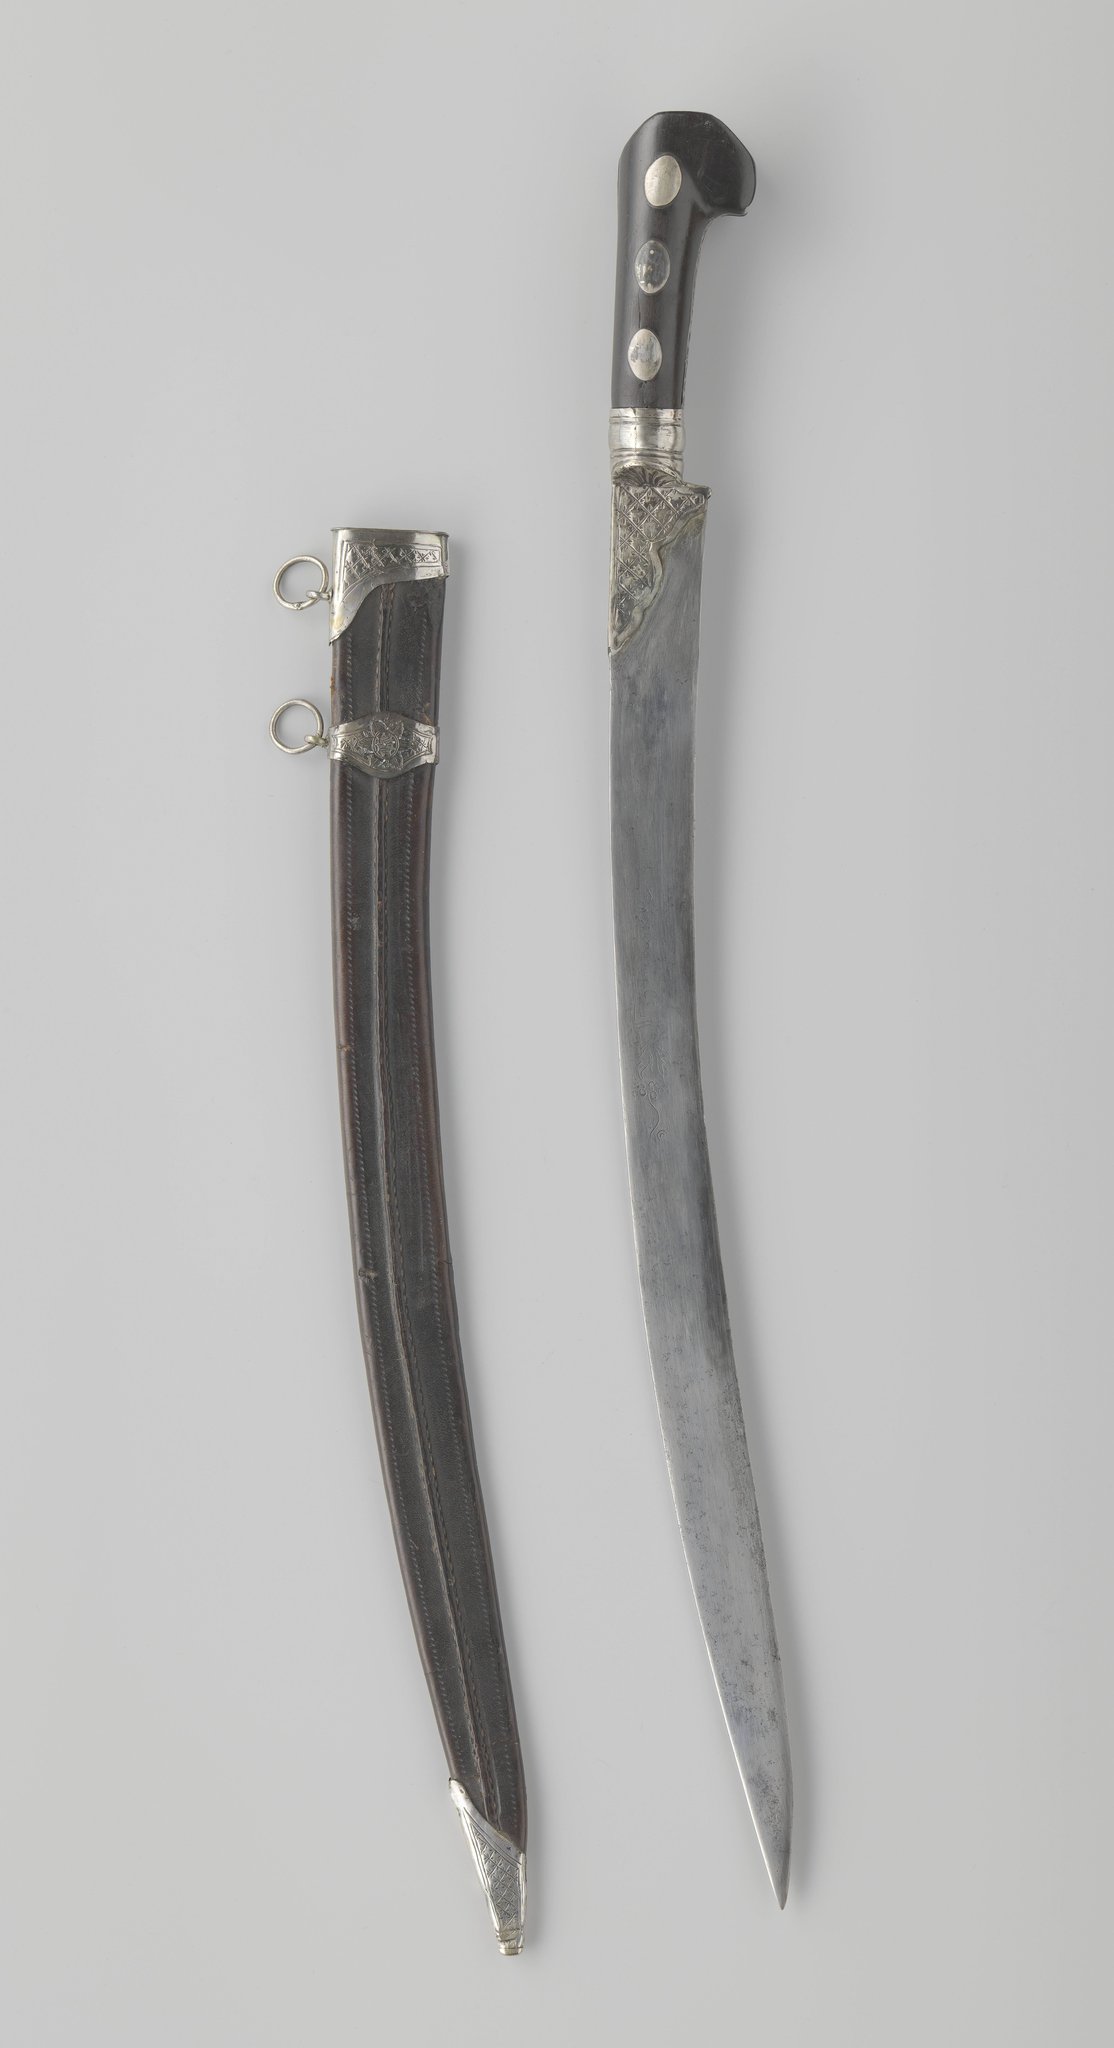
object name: yatagan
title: Yatagan met ebbenhouten gevest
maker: Anonymous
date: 1500-1699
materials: wood, iron, leather, silver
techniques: inlay, tanning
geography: turkey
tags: tromp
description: Yatagan, from European Turkey.